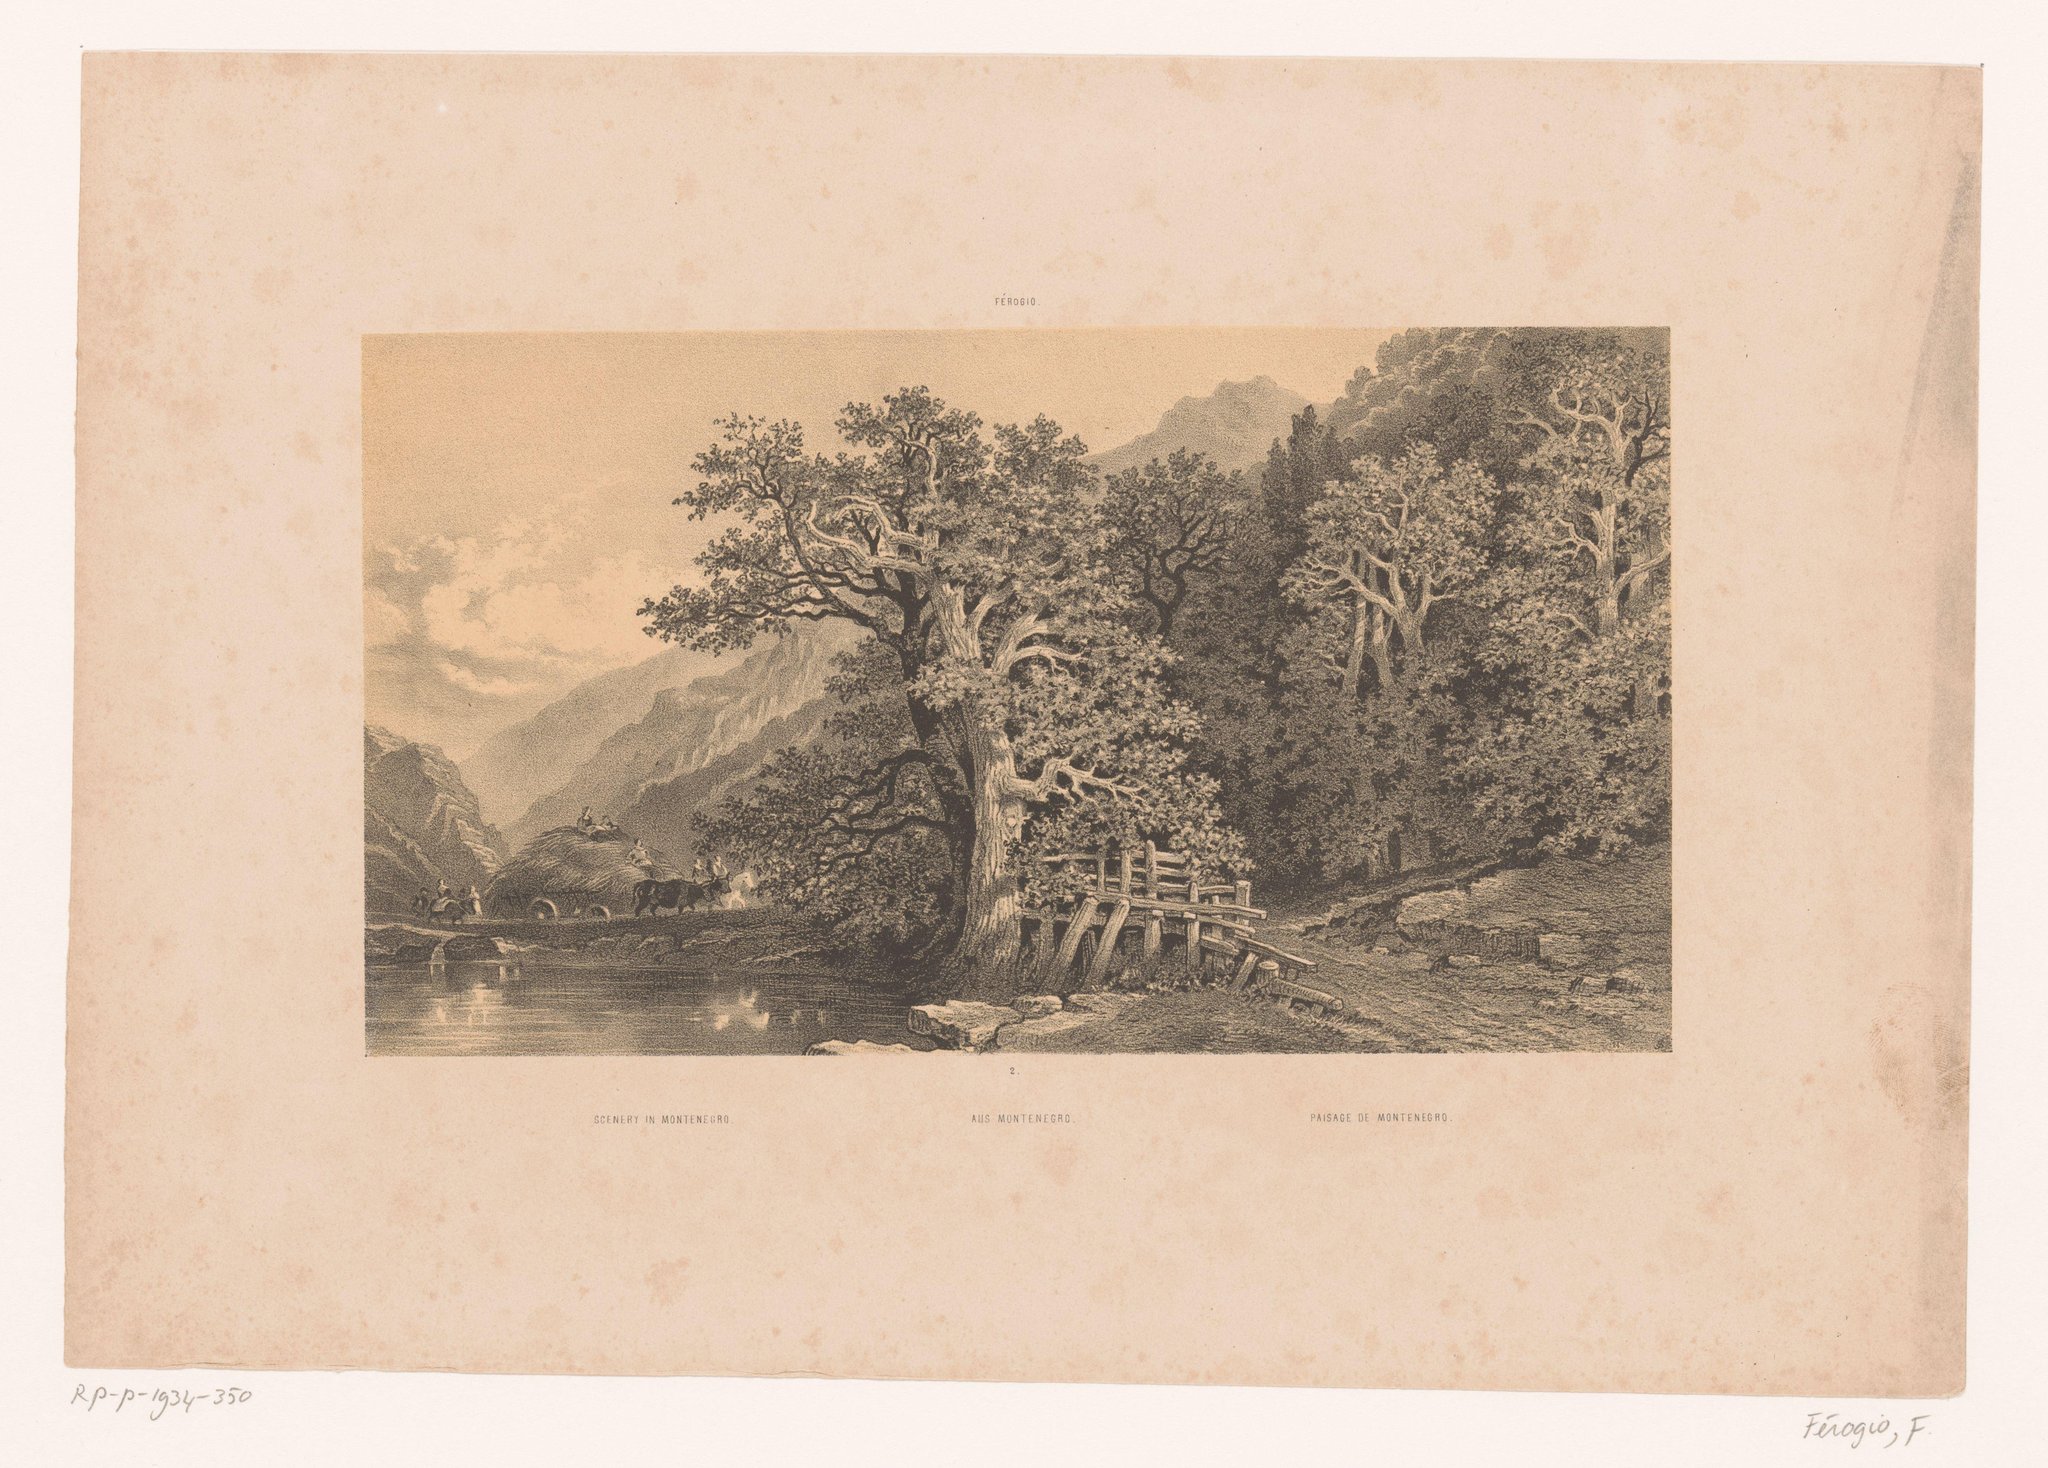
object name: print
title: Berglandschap met water en een hooiwagen op een pad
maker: fortuné férogio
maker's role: print maker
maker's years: 1805-1888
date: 1829-1875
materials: paper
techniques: tone lithography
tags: road, path, forest, wood, pond, pool, mountains (+ landscape with figures, staffage), hay-wagon